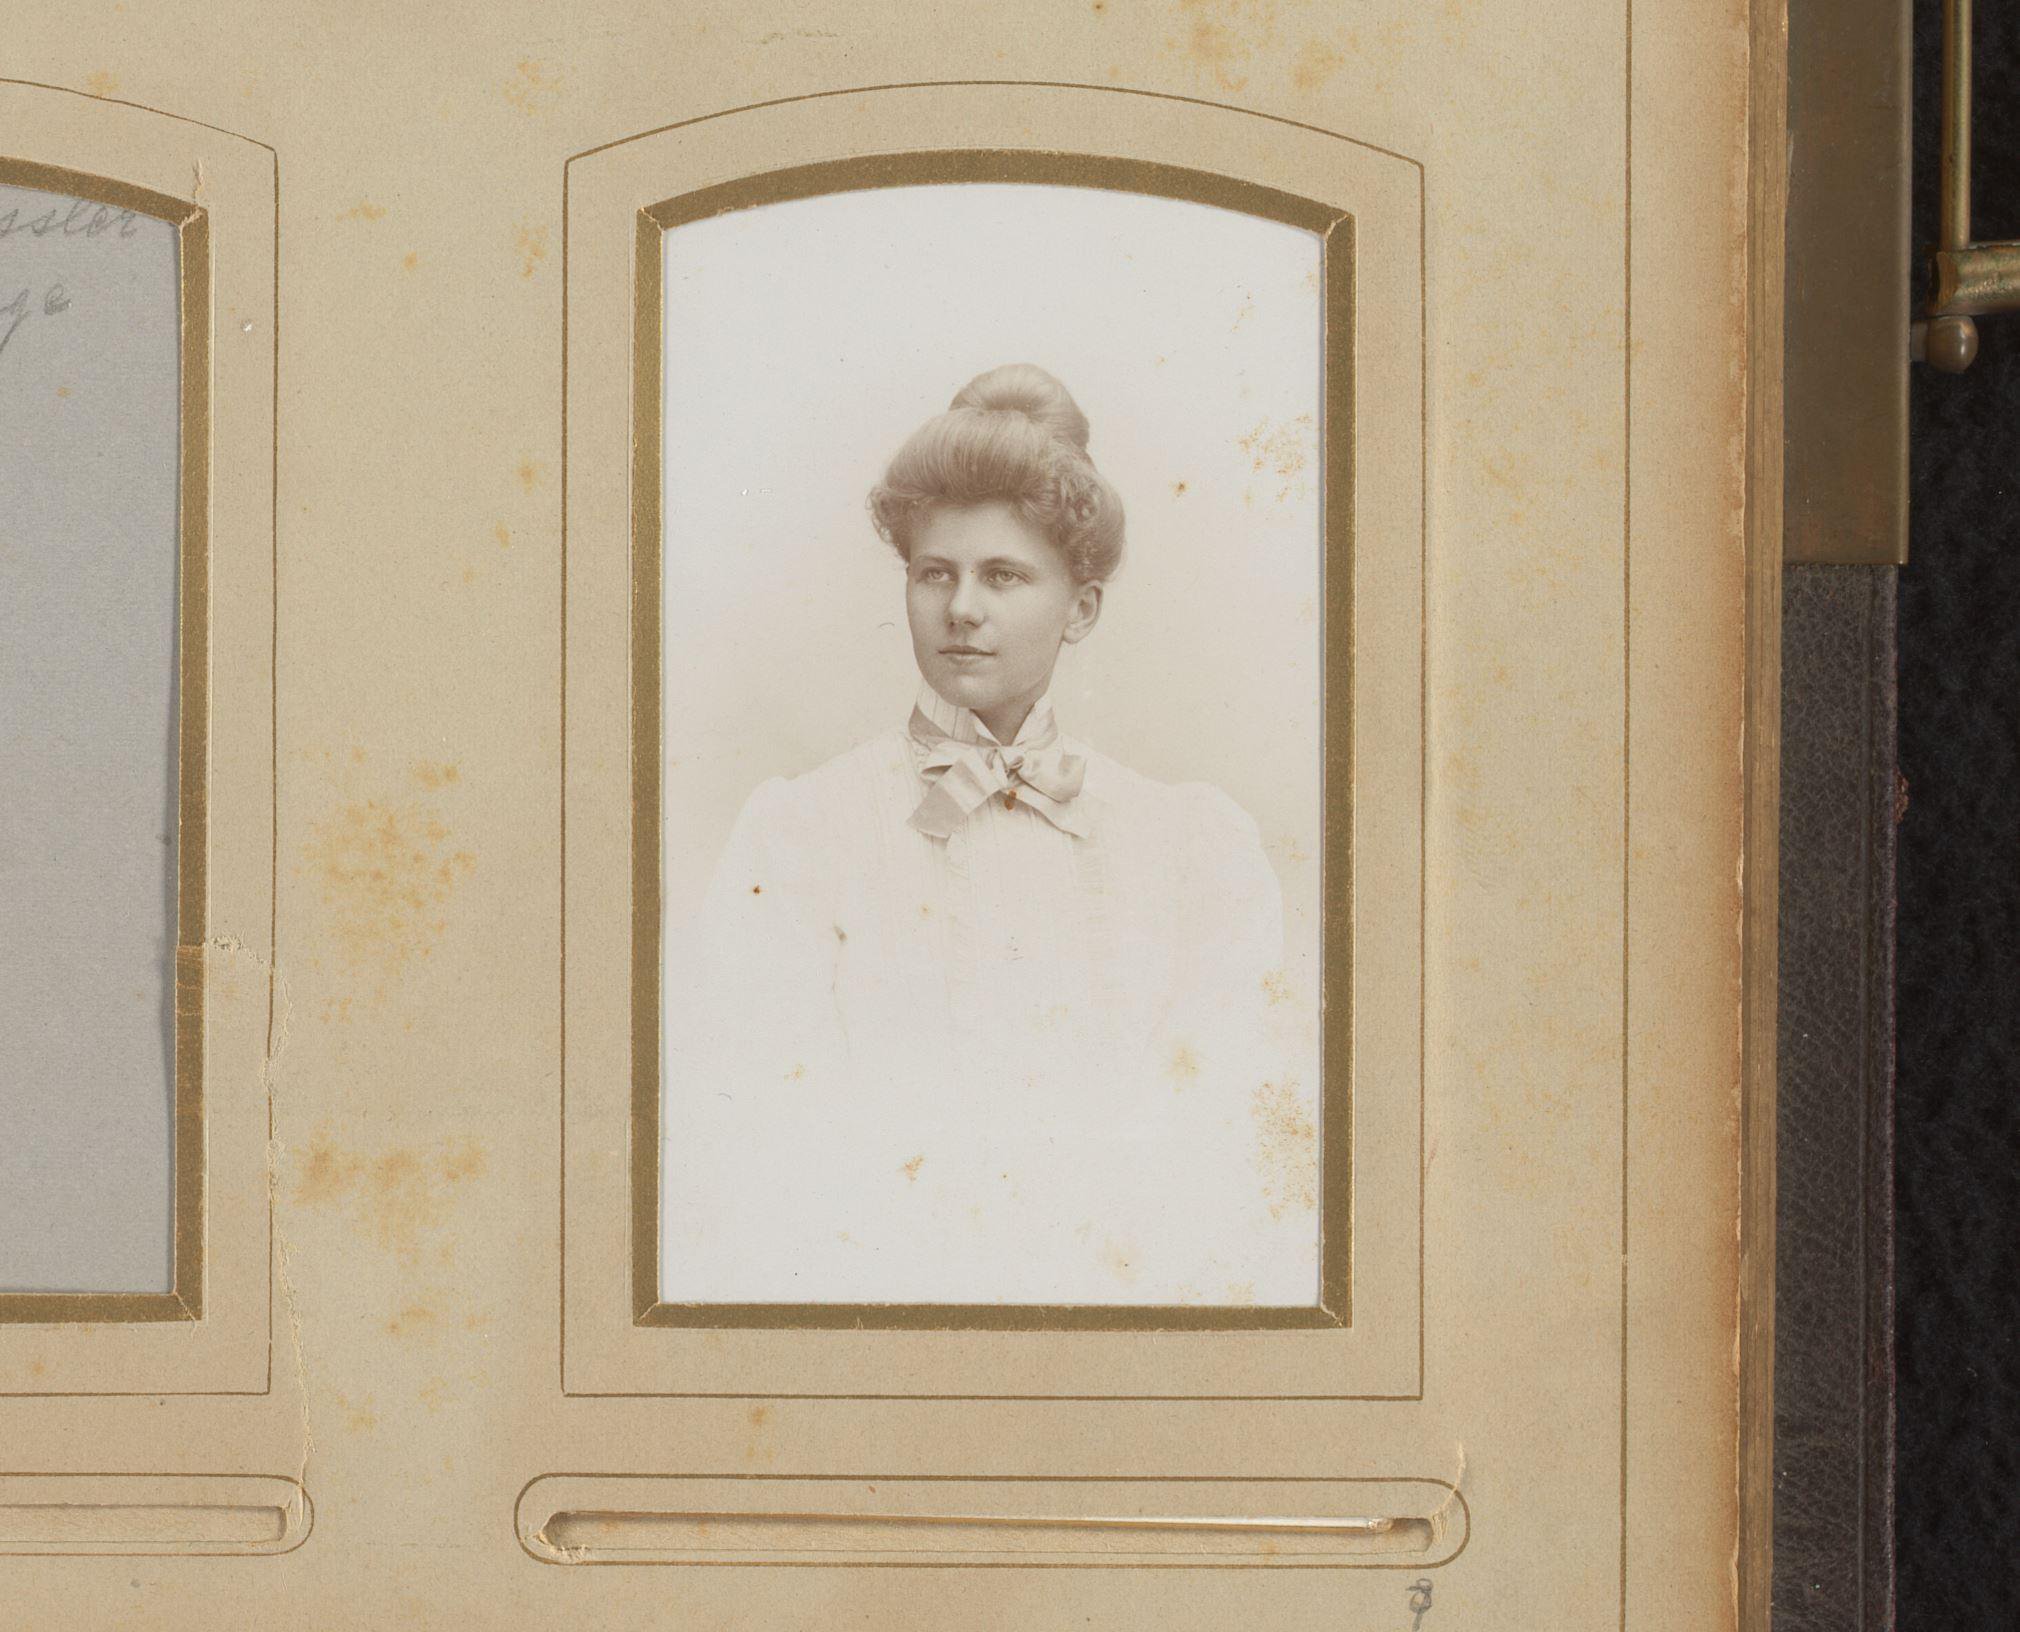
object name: photograph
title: Portret van Margo Kessler-de Lange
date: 1880-1920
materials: paper, photographic support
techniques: photography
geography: maastricht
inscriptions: inscription: ‘(MJJ) Margo Kessler de Lange’